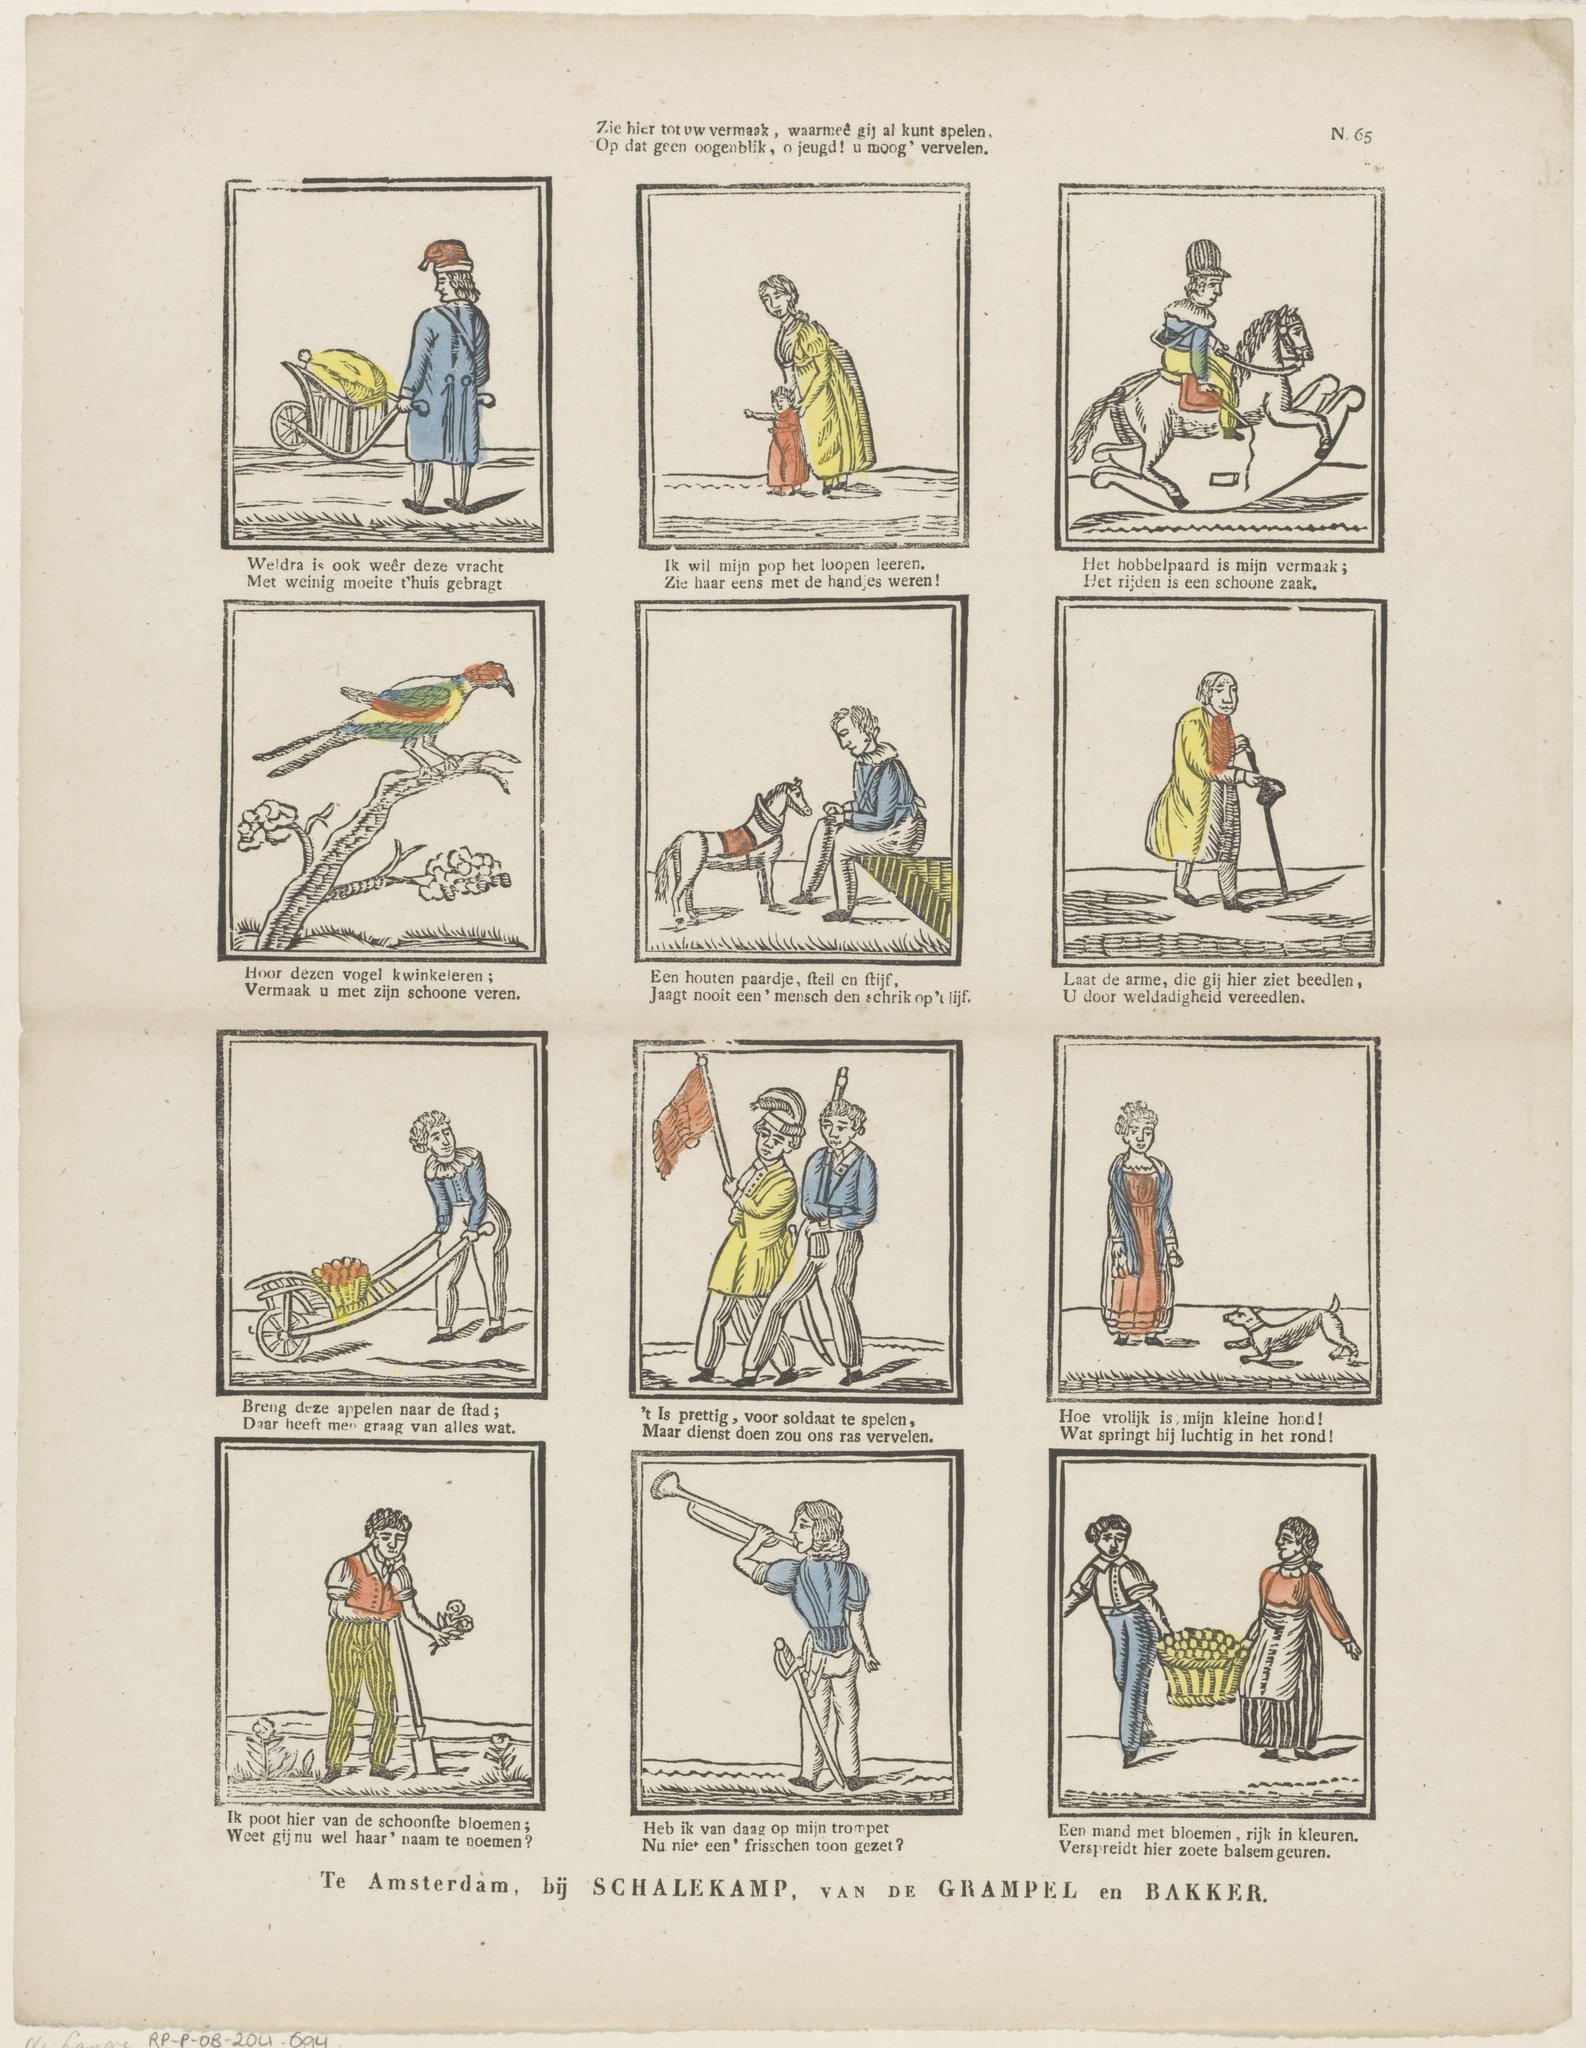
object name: popular print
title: Zie hier tot uw vermaak, waarmeê gij al kunt spelen, / Op dat geen ogenblik, o jeugd! u moog' vervelen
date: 1822-1849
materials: paper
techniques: colour, letterpress printing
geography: netherlands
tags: children's games and plays, walking, hiking (recreation), human types, birds, gardening, rocking-horse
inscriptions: collector's mark: Lugt 2760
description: Blad met 12 voorstellingen van figuren, bezigheden en kinderspelen. Onder elke afbeelding een tweeregelig vers. Genummerd rechtsboven: N. 65.